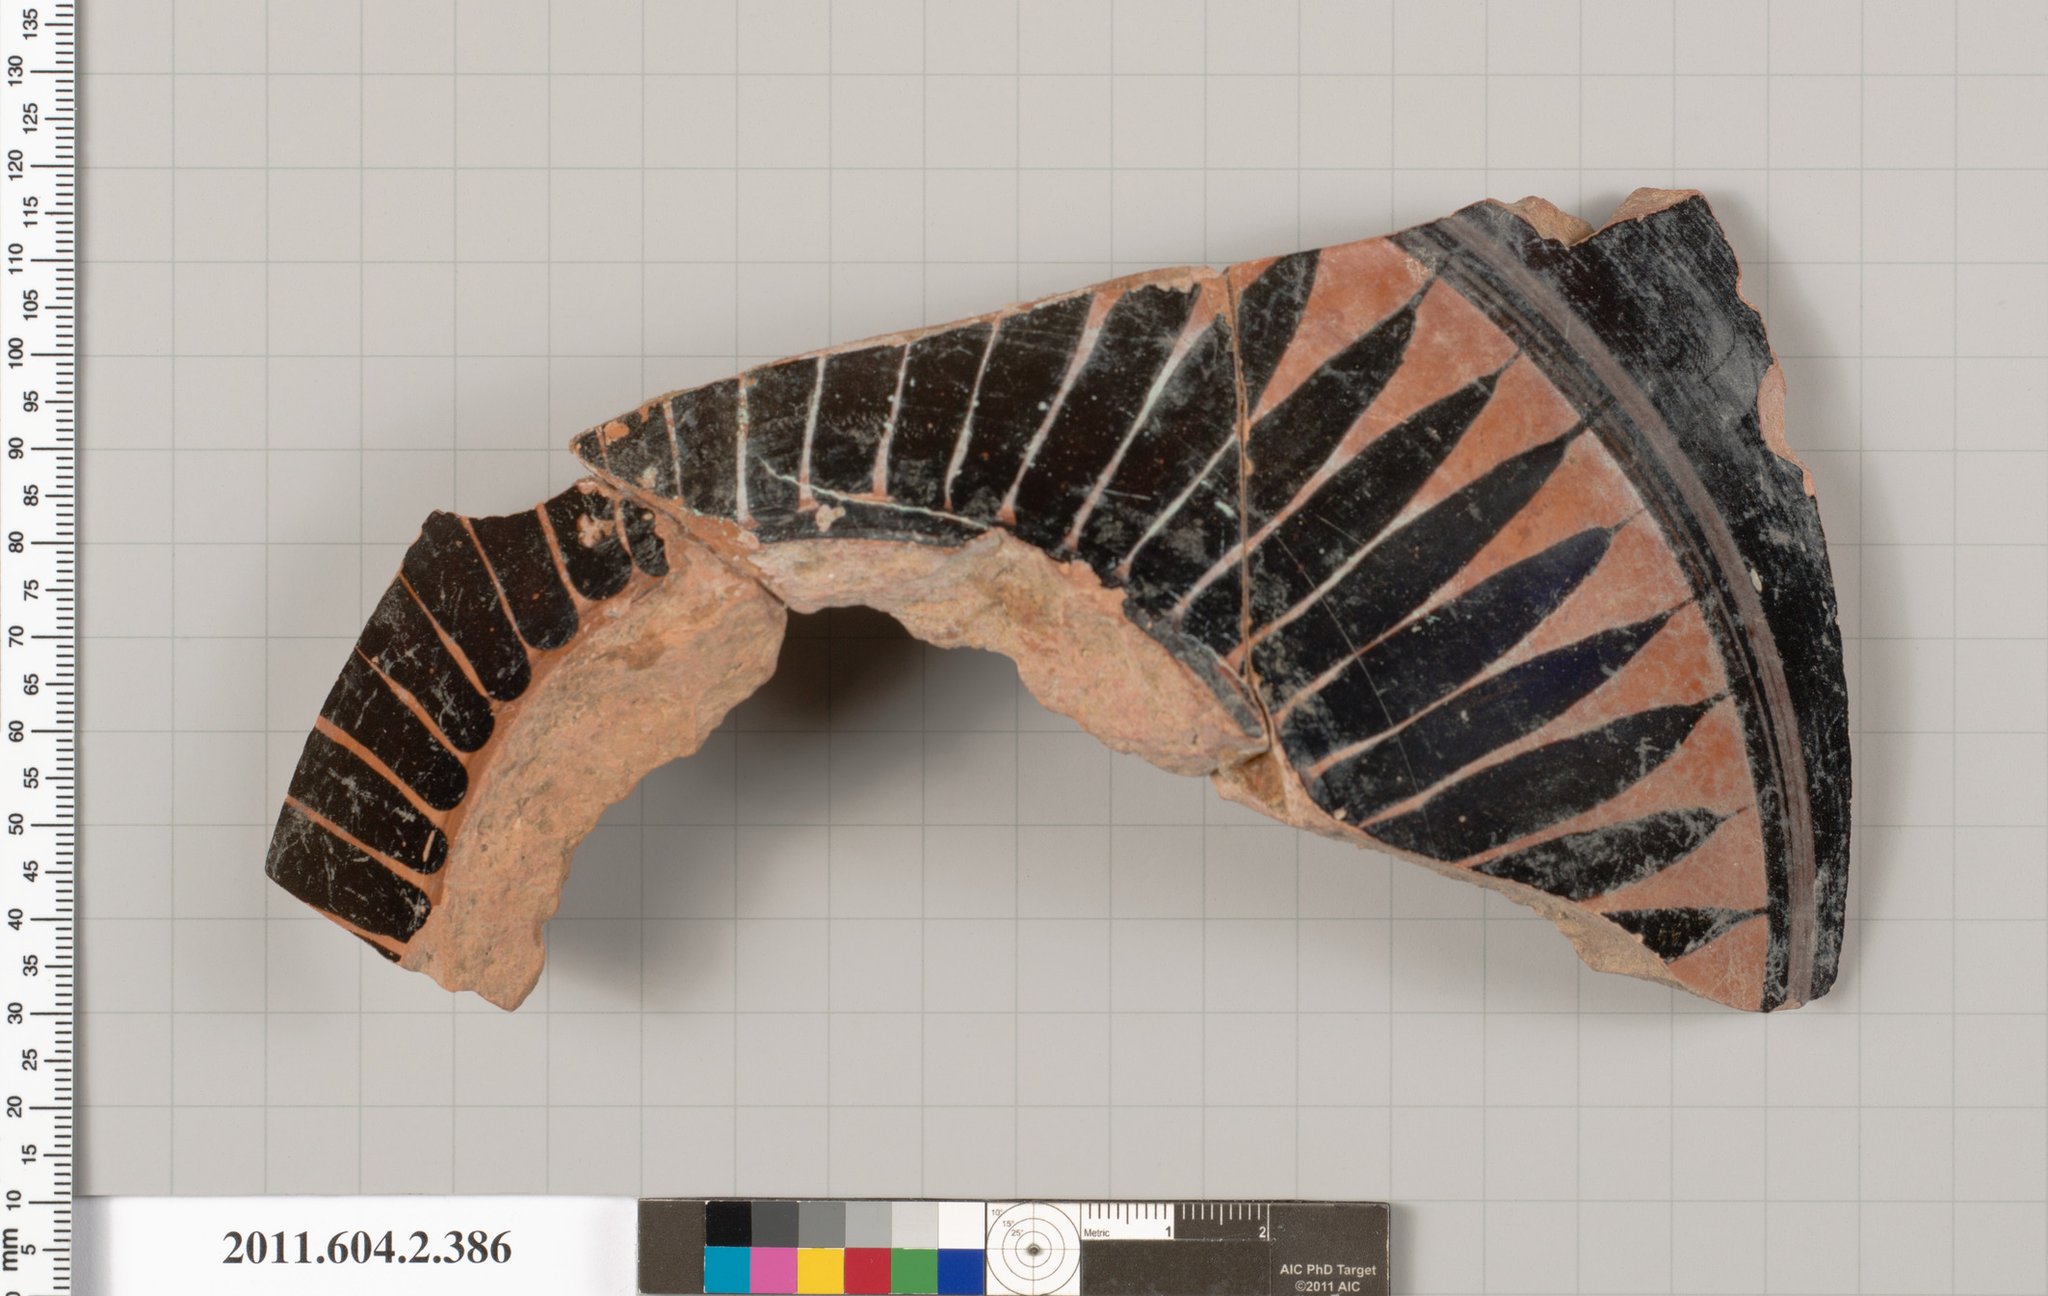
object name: column krater fragment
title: Terracotta fragment of a column-krater (bowl for mixing wine and water)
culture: greek, attic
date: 450-430 BCE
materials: terracotta